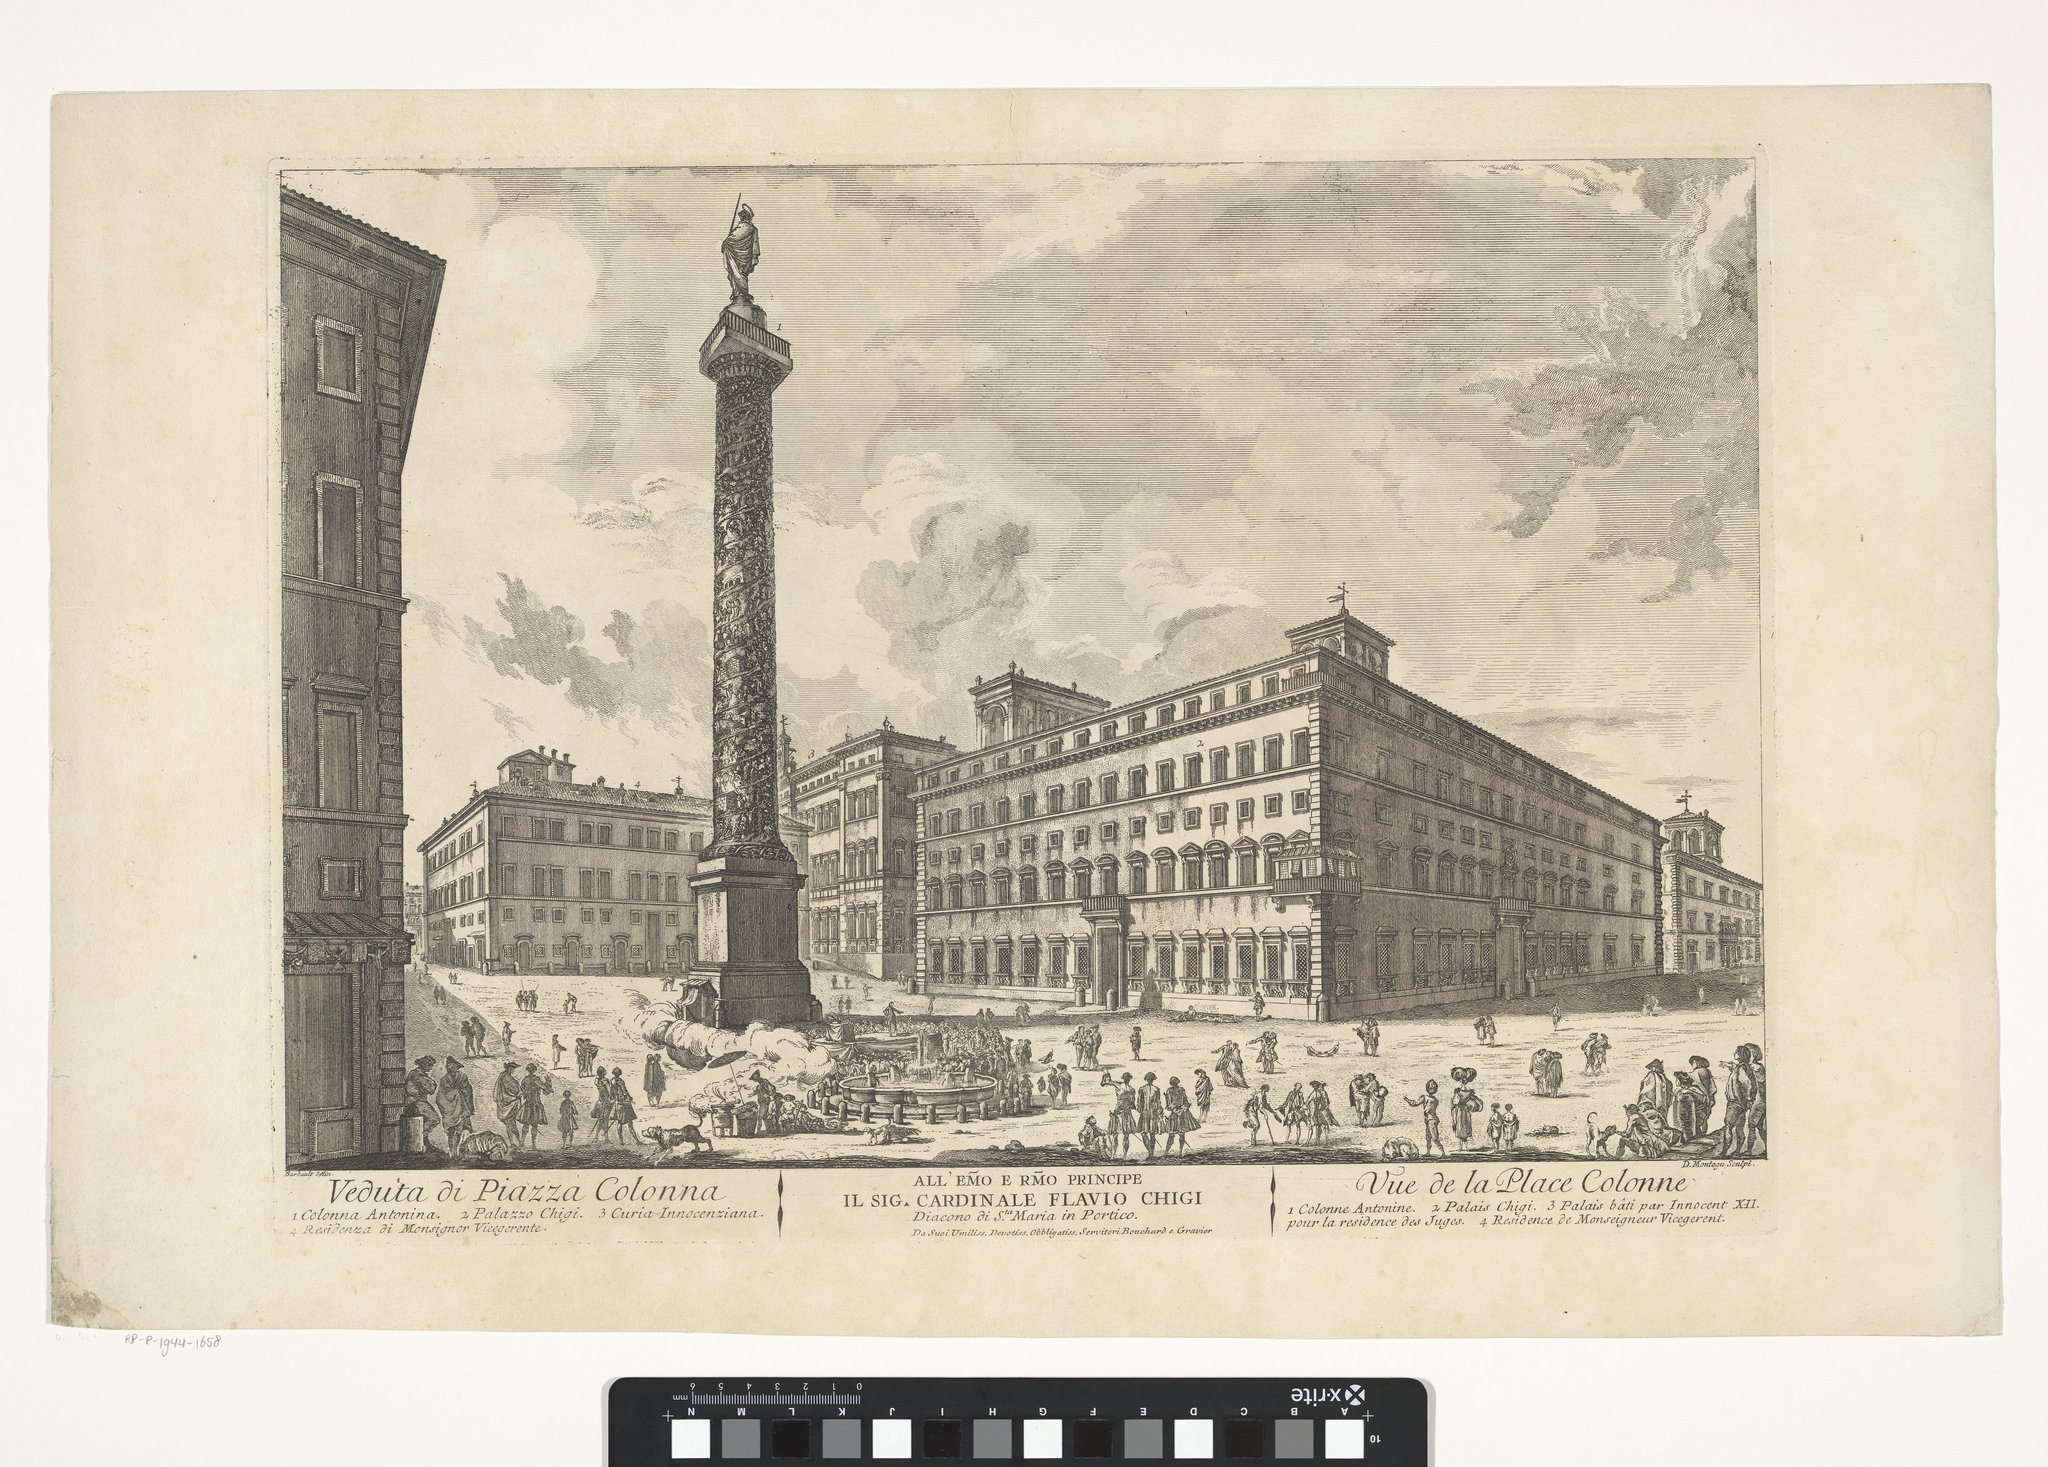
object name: print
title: Veduta di Piazza Colonna / Vue de la Place Colonne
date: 1750-1799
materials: paper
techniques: etching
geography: italy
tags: square, place, circus, etc., city-view, and landscape with man-made constructions, triumphal column with helical friezes, rome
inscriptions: collector's mark: Lugt 2228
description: Gezicht op Piazza Colonna met de Zuil van Marcus Aurelius te Rome. Titels en verklarende lijsten met nummers in het Frans en Italiaans en een opdracht in de ondermarge.